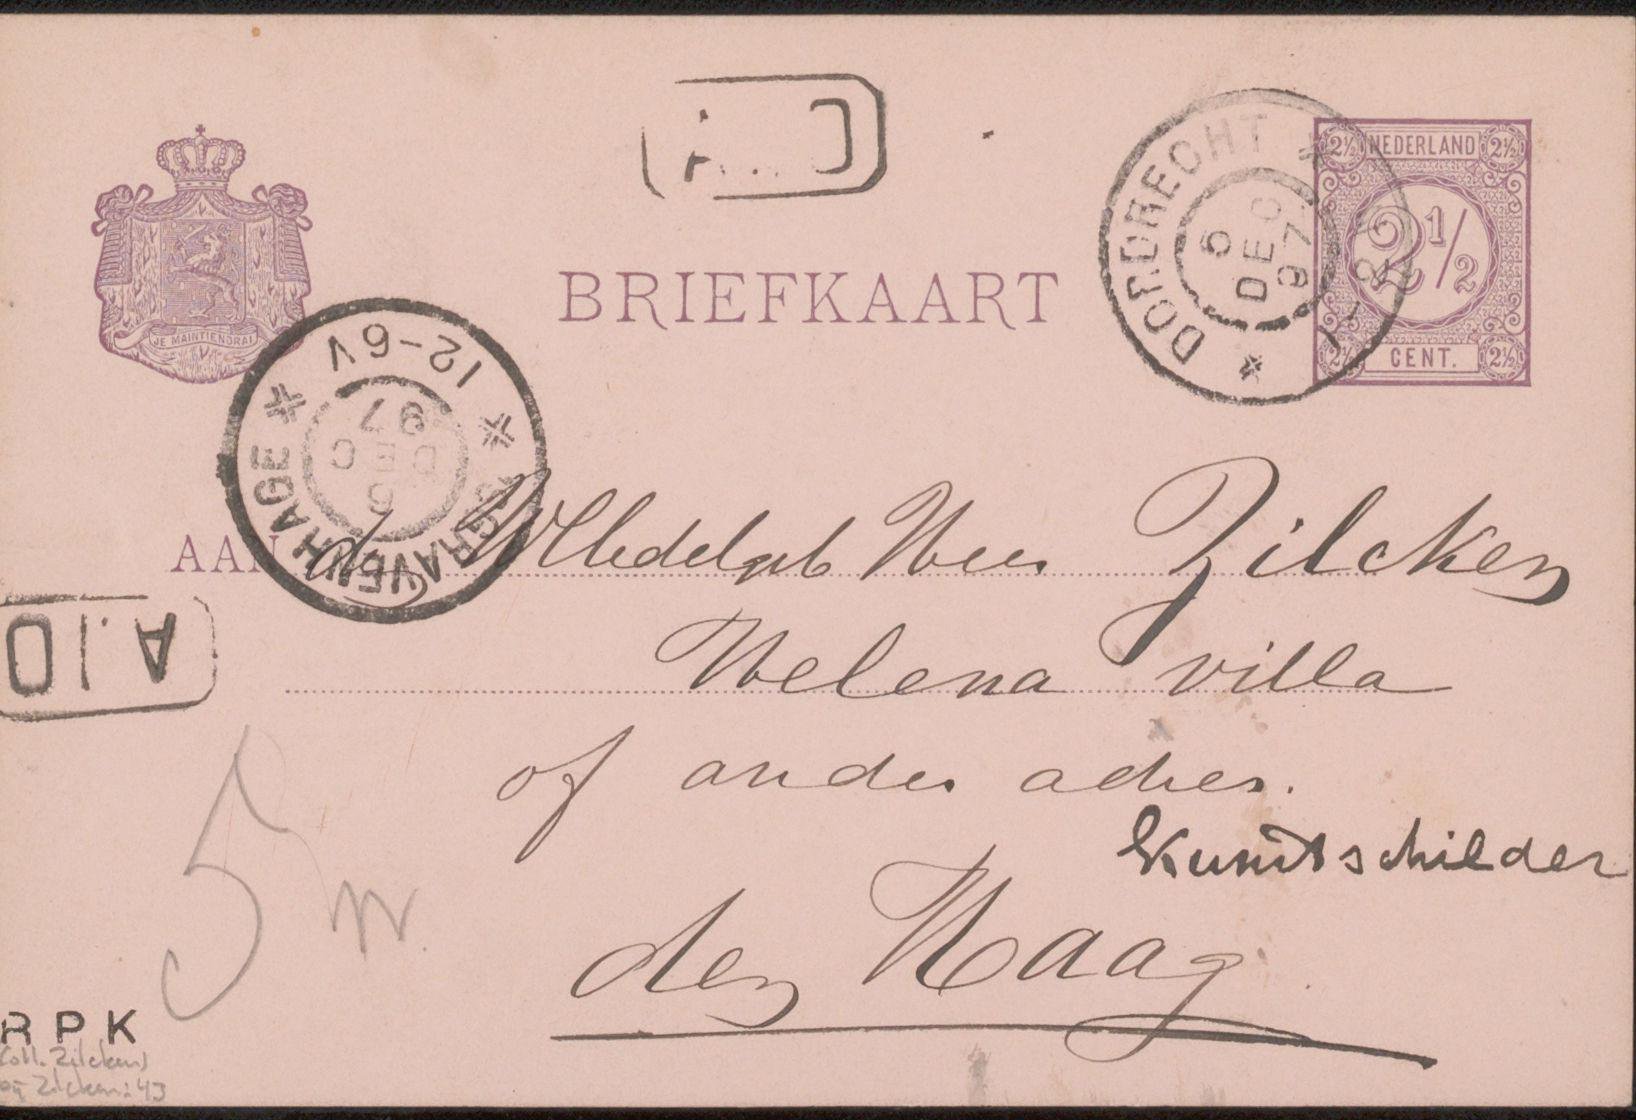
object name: postcard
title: Briefkaart aan Philip Zilcken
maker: hidde nijland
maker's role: kunstverzamelaar, verzamelaar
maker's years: 1853-1931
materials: cardboard, ink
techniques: pen, writing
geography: dordrecht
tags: painter, draughtsman, jan toorop, philip zilcken, photography, cinematography, money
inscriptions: collector's mark: ‘RPK’